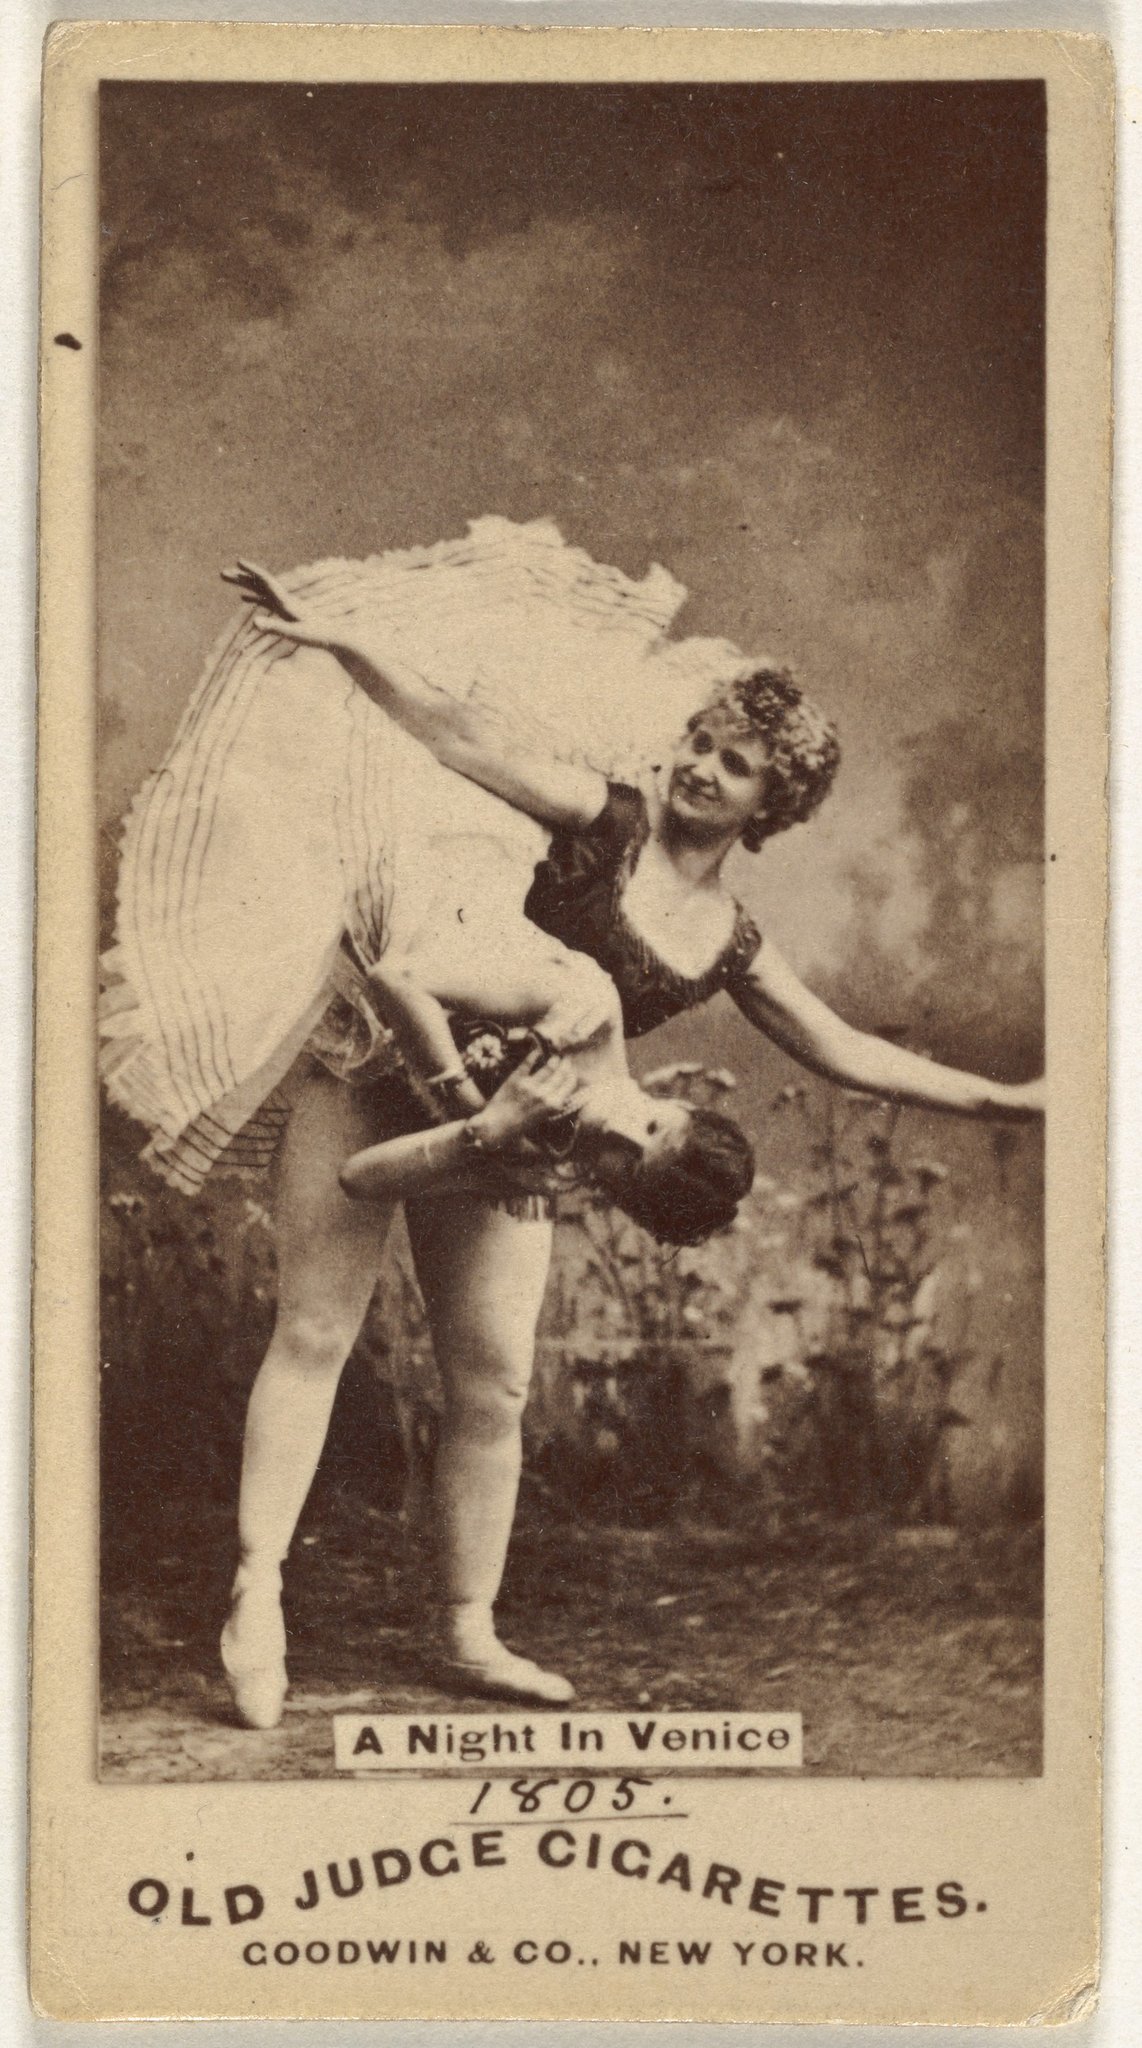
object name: photograph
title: A Night in Venice, from the Actors and Actresses series (N171) for Old Judge Cigarettes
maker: goodwin & company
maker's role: publisher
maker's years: 1850-1950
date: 1886-1890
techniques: albumen silver print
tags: women,actresses,dancers